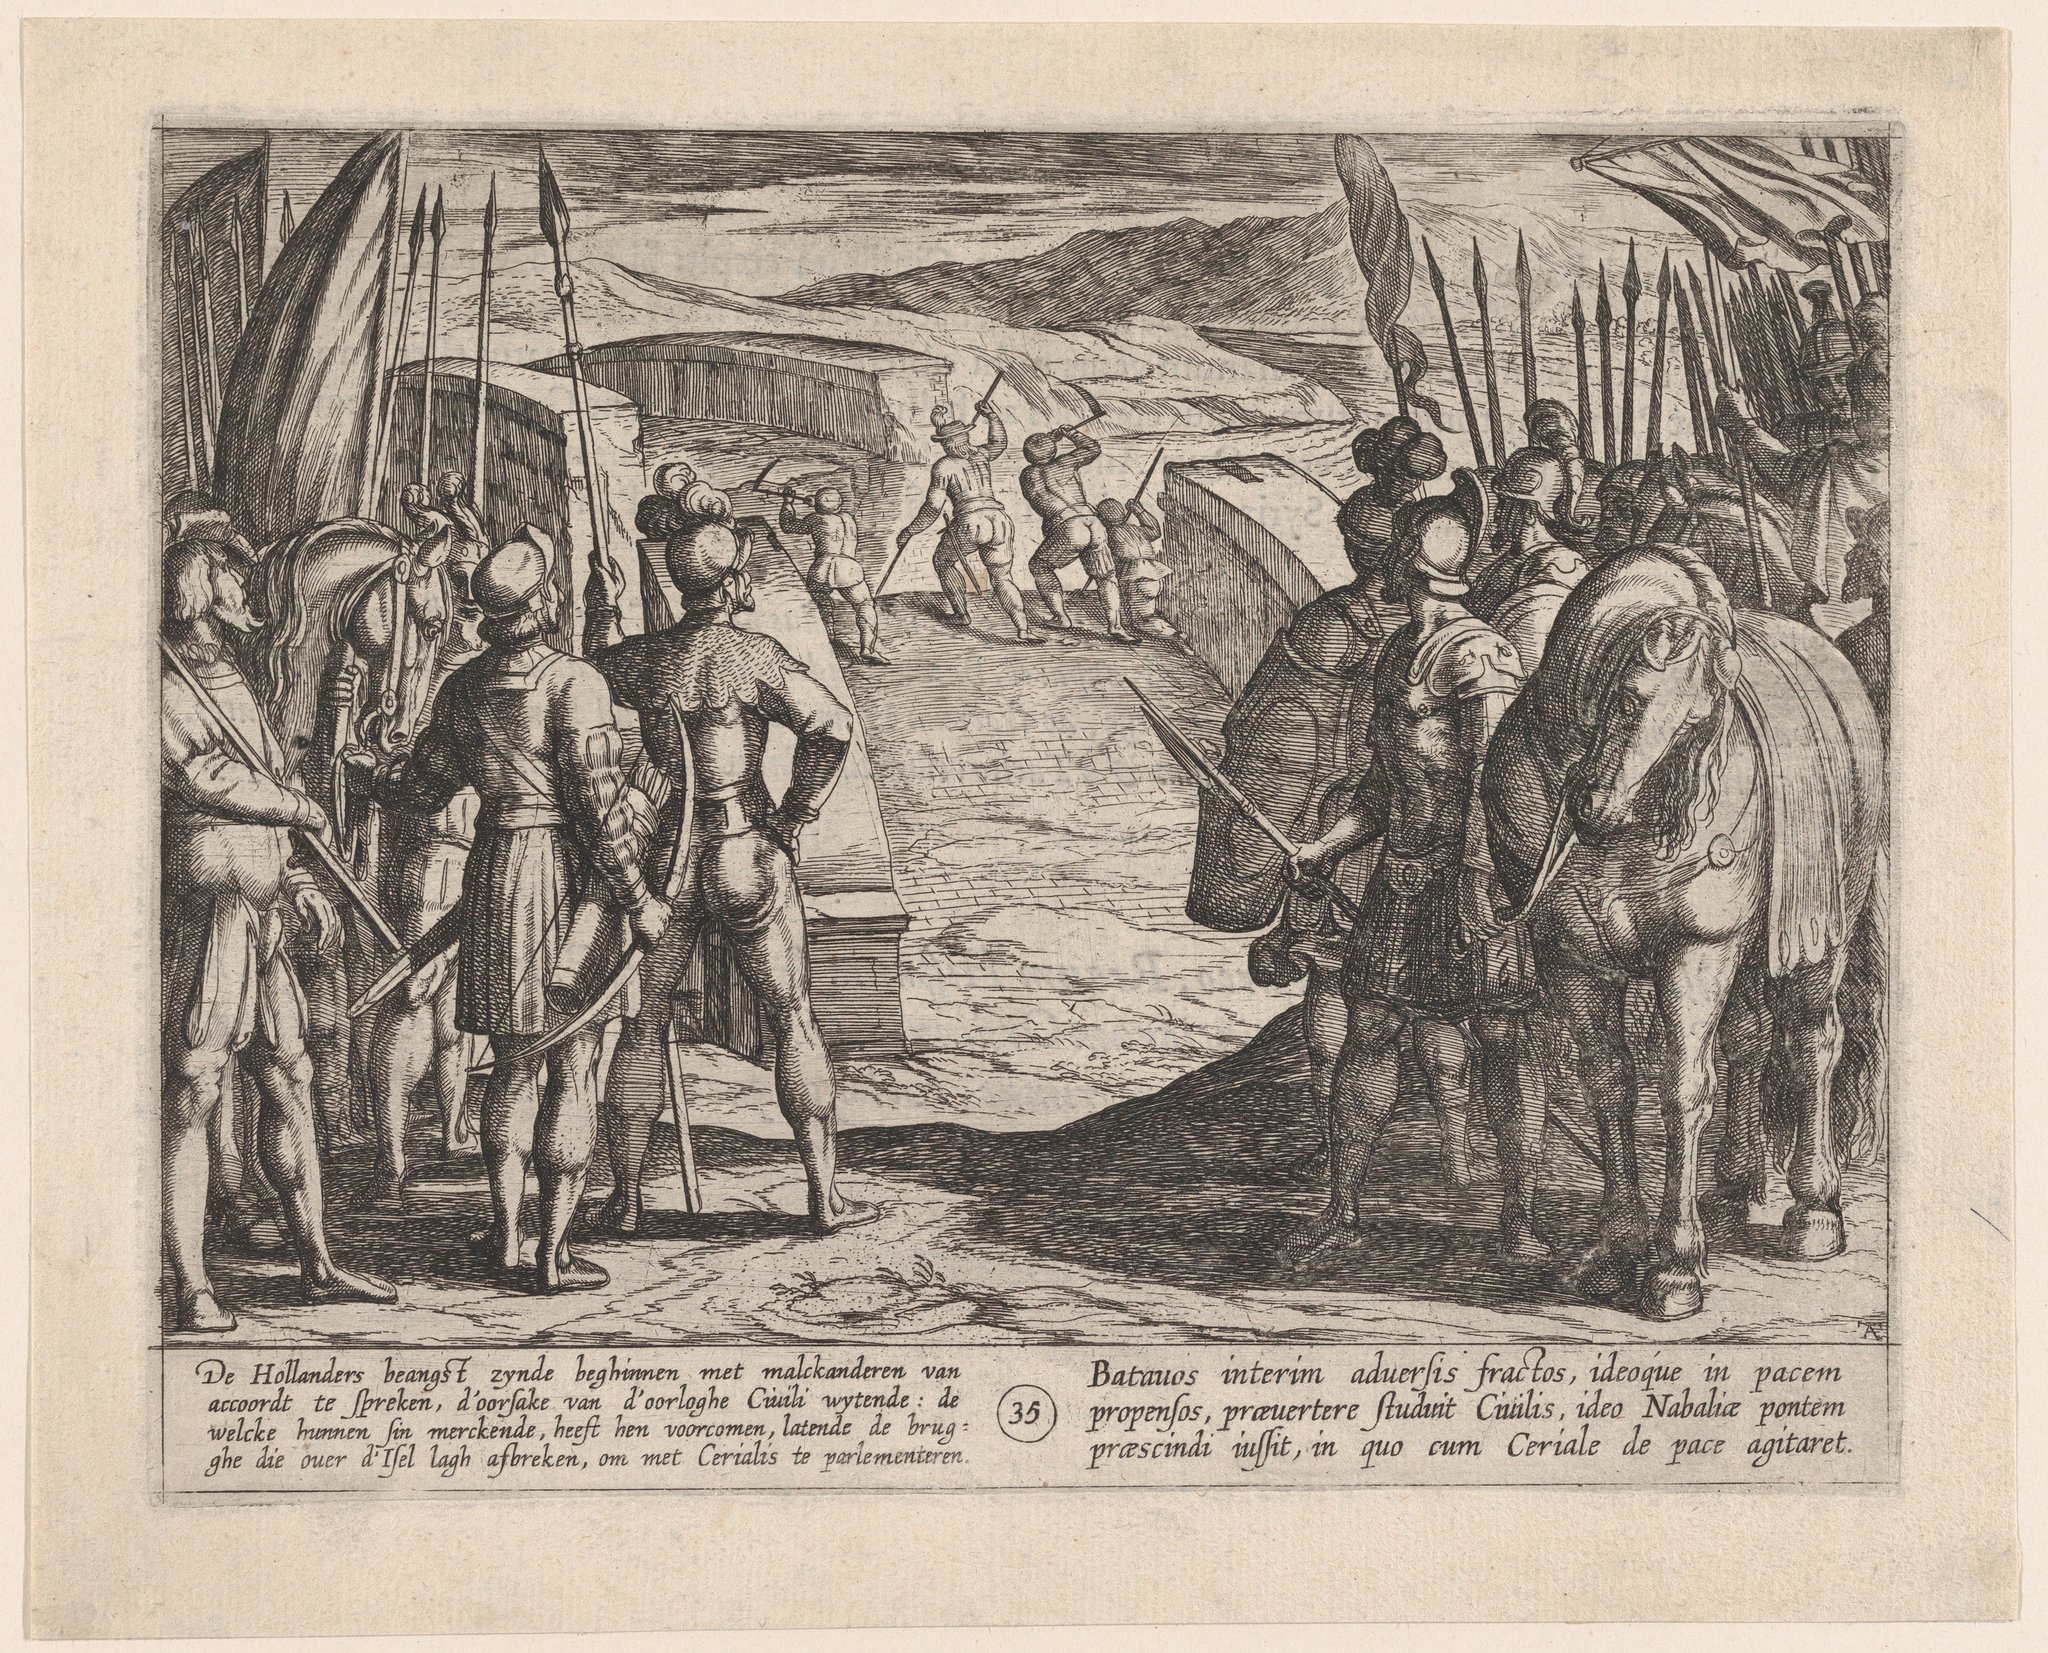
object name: print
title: Plate 35: The Batavians Become Afraid and Begin Peace Talks, from The War of the Romans Against the Batavians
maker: antonio tempesta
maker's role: artist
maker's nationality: italian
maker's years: 1555-1630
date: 1611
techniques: etching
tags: soldiers,spears,men,horses